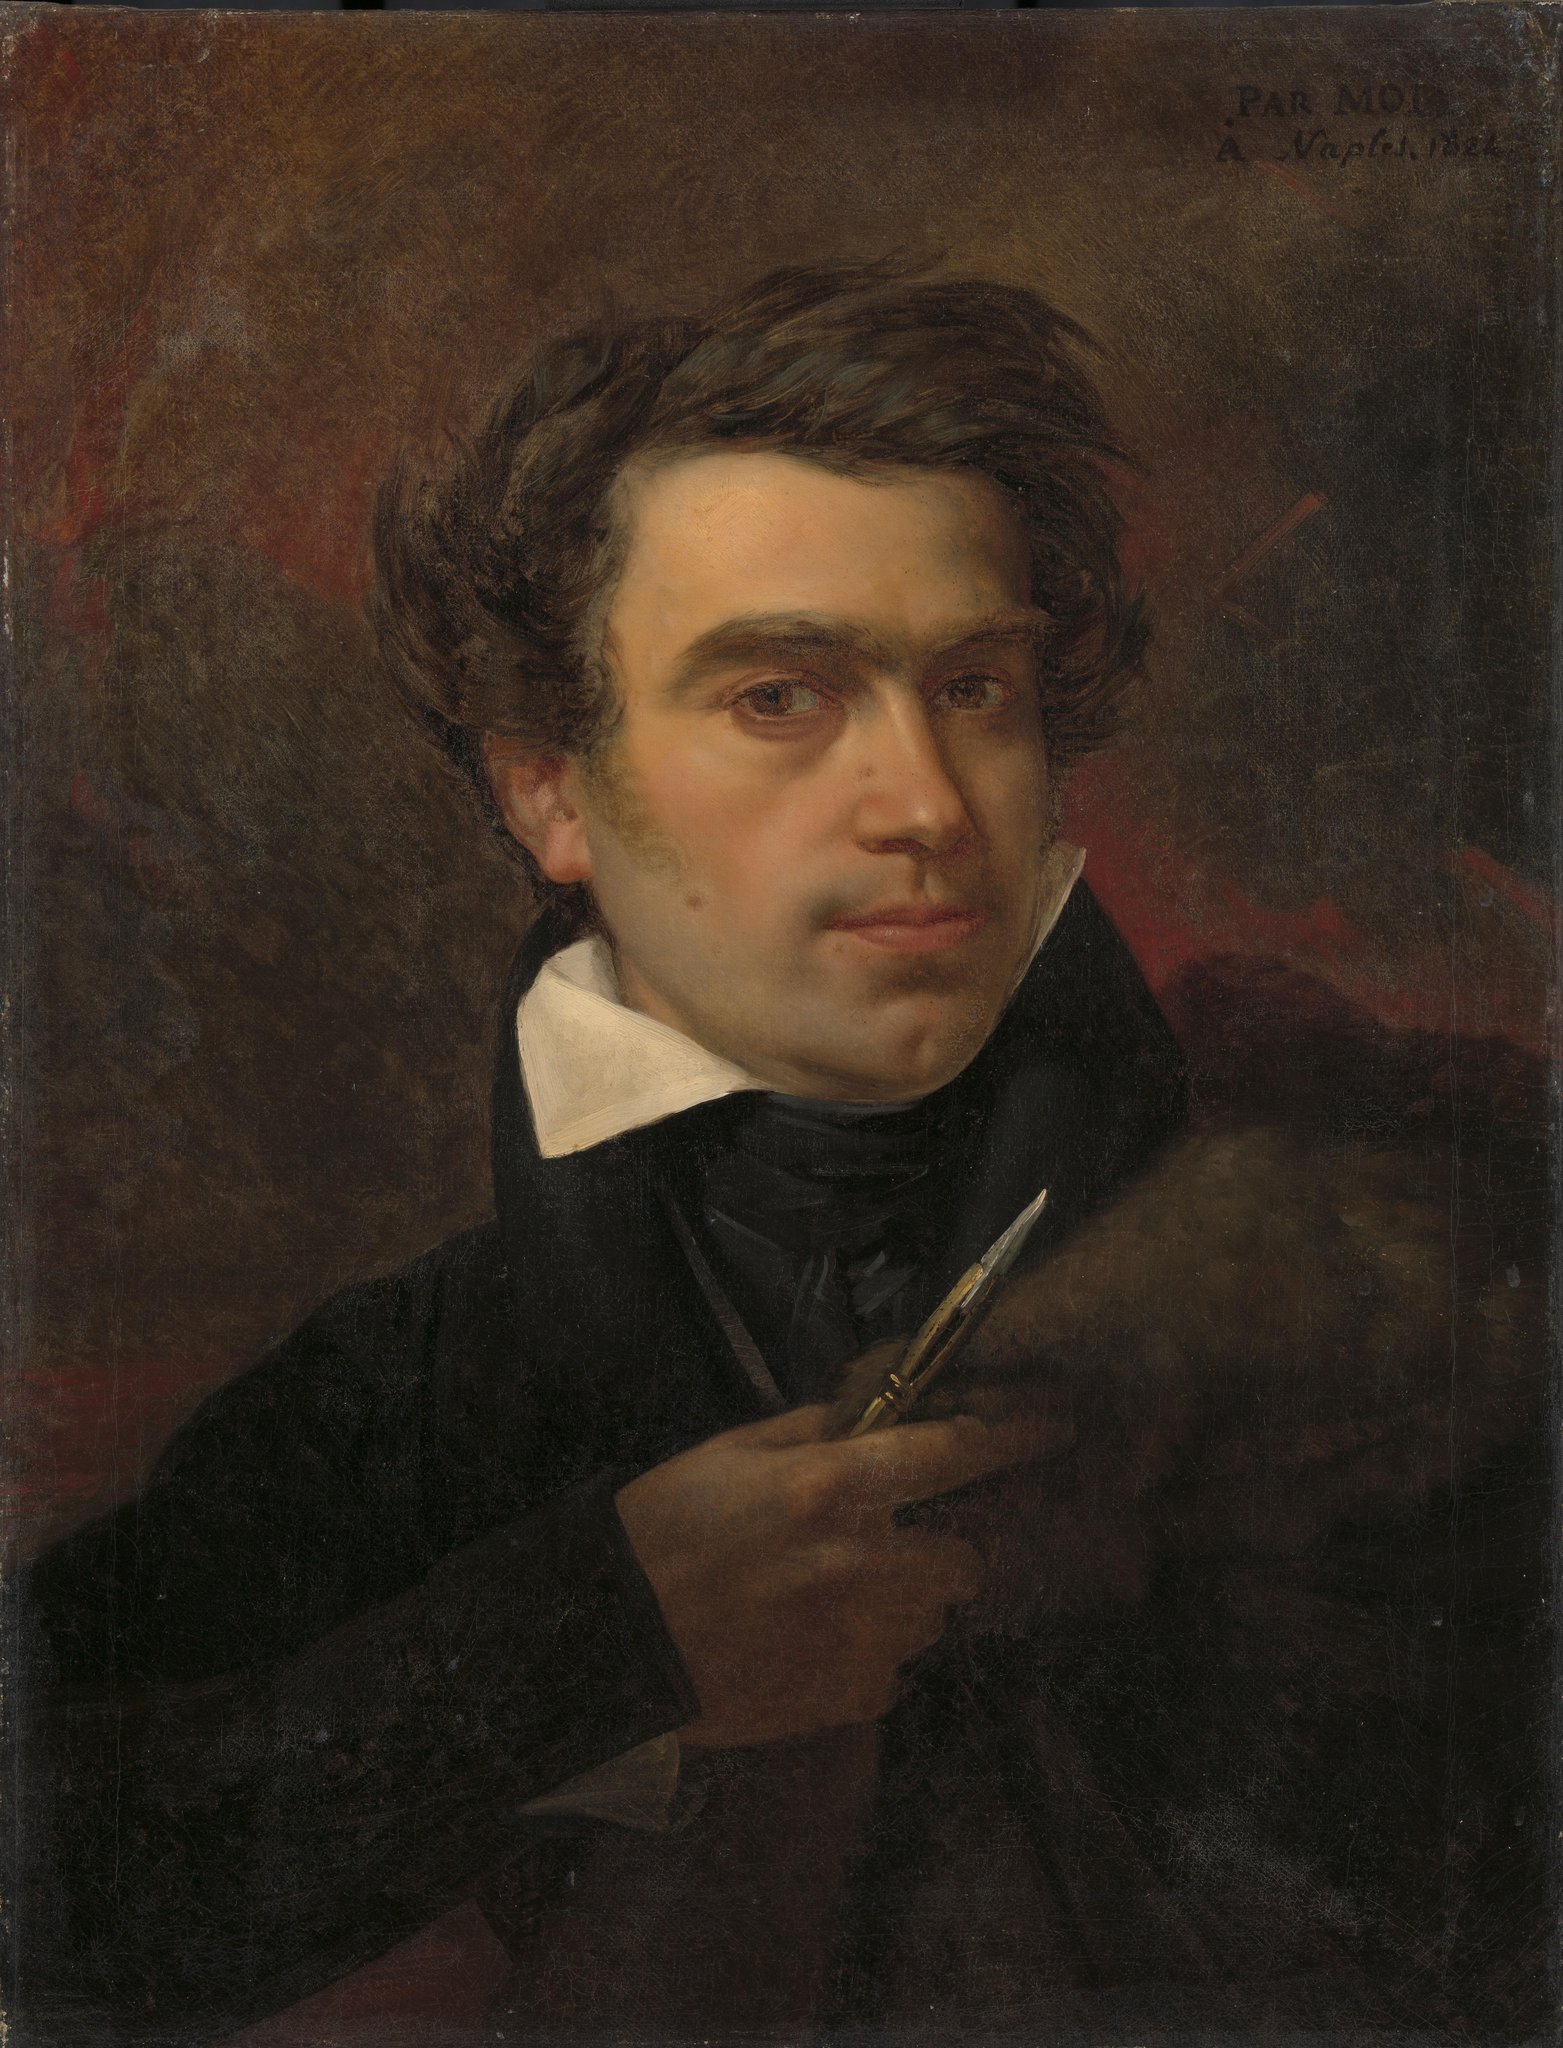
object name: painting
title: Self Portrait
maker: pierre van hanselaere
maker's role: painter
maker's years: 1786-1862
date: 1824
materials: canvas, oil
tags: painter, pierre van hanselaere, historical persons, portrait, self-portrait of painter, portrait, self-portrait of artist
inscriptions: signature and date: ‘Par moi à Naples. 1824’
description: Zelfportret van de schilder Pierre Van Hanselaere. Buste, met een penseel in de rechterhand.